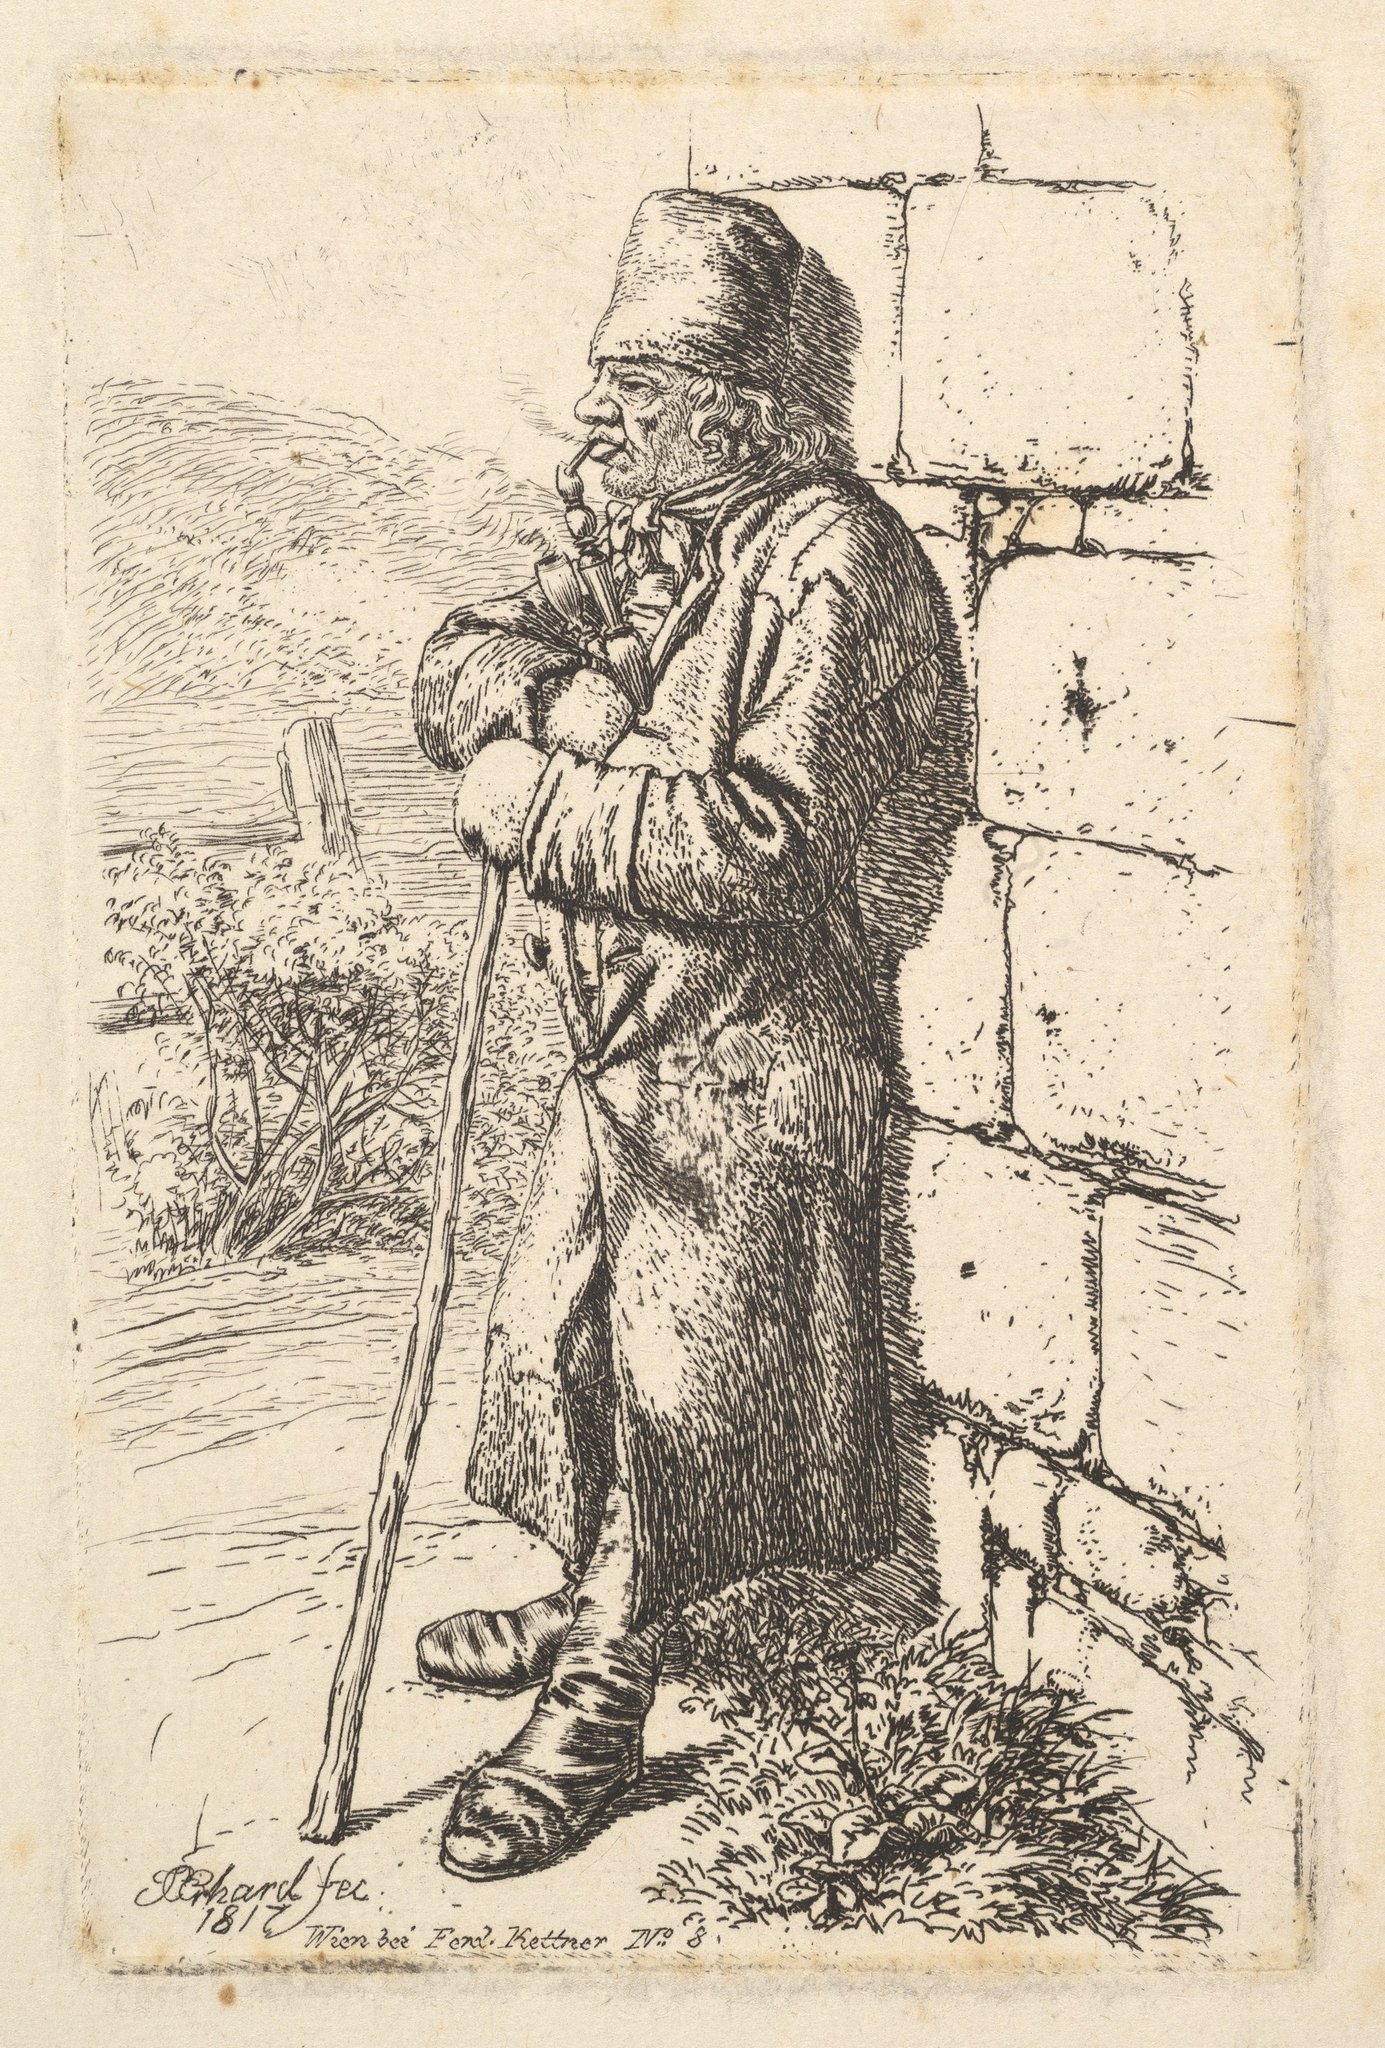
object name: print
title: The Tobacco Smoker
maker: johann christoph erhard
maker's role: artist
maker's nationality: german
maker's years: 1795-1822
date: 1817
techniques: etching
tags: men,smoking